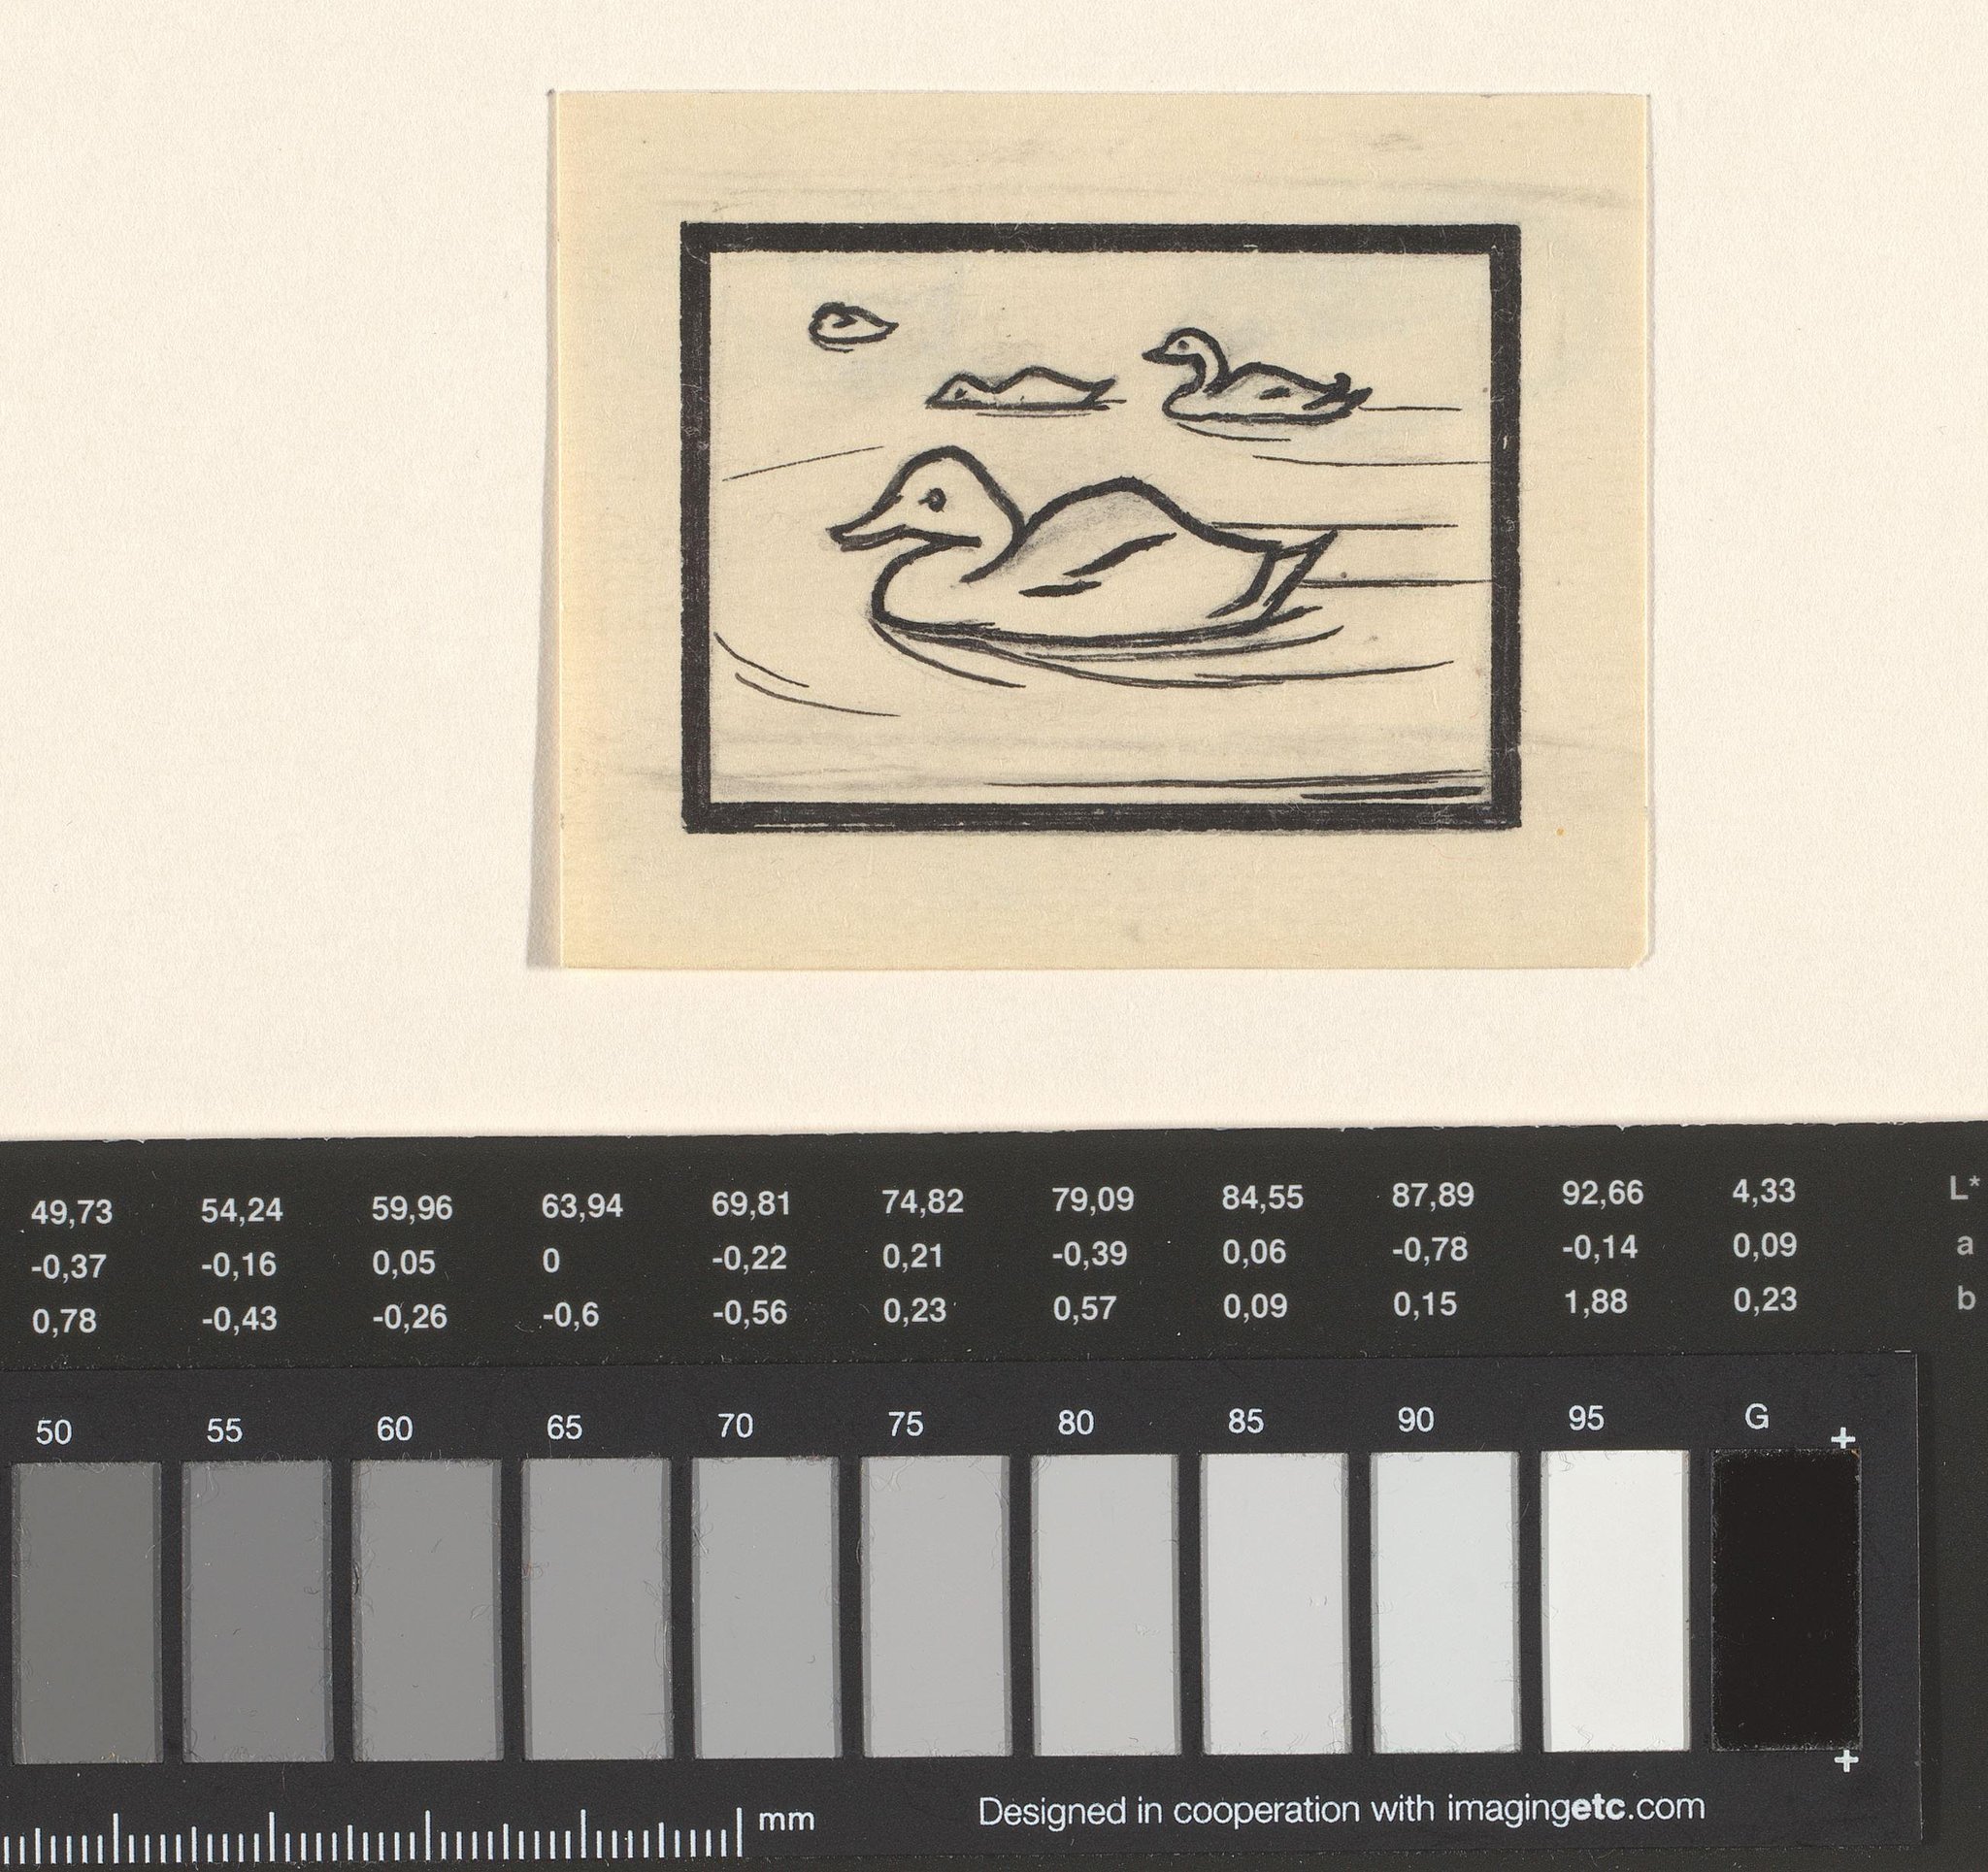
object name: drawing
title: Eenden in het water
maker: julie de graag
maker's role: draughtsman, print maker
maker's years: 1877-1924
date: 1887-1924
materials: ink, paper, pencil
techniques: pen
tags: water-birds: duck